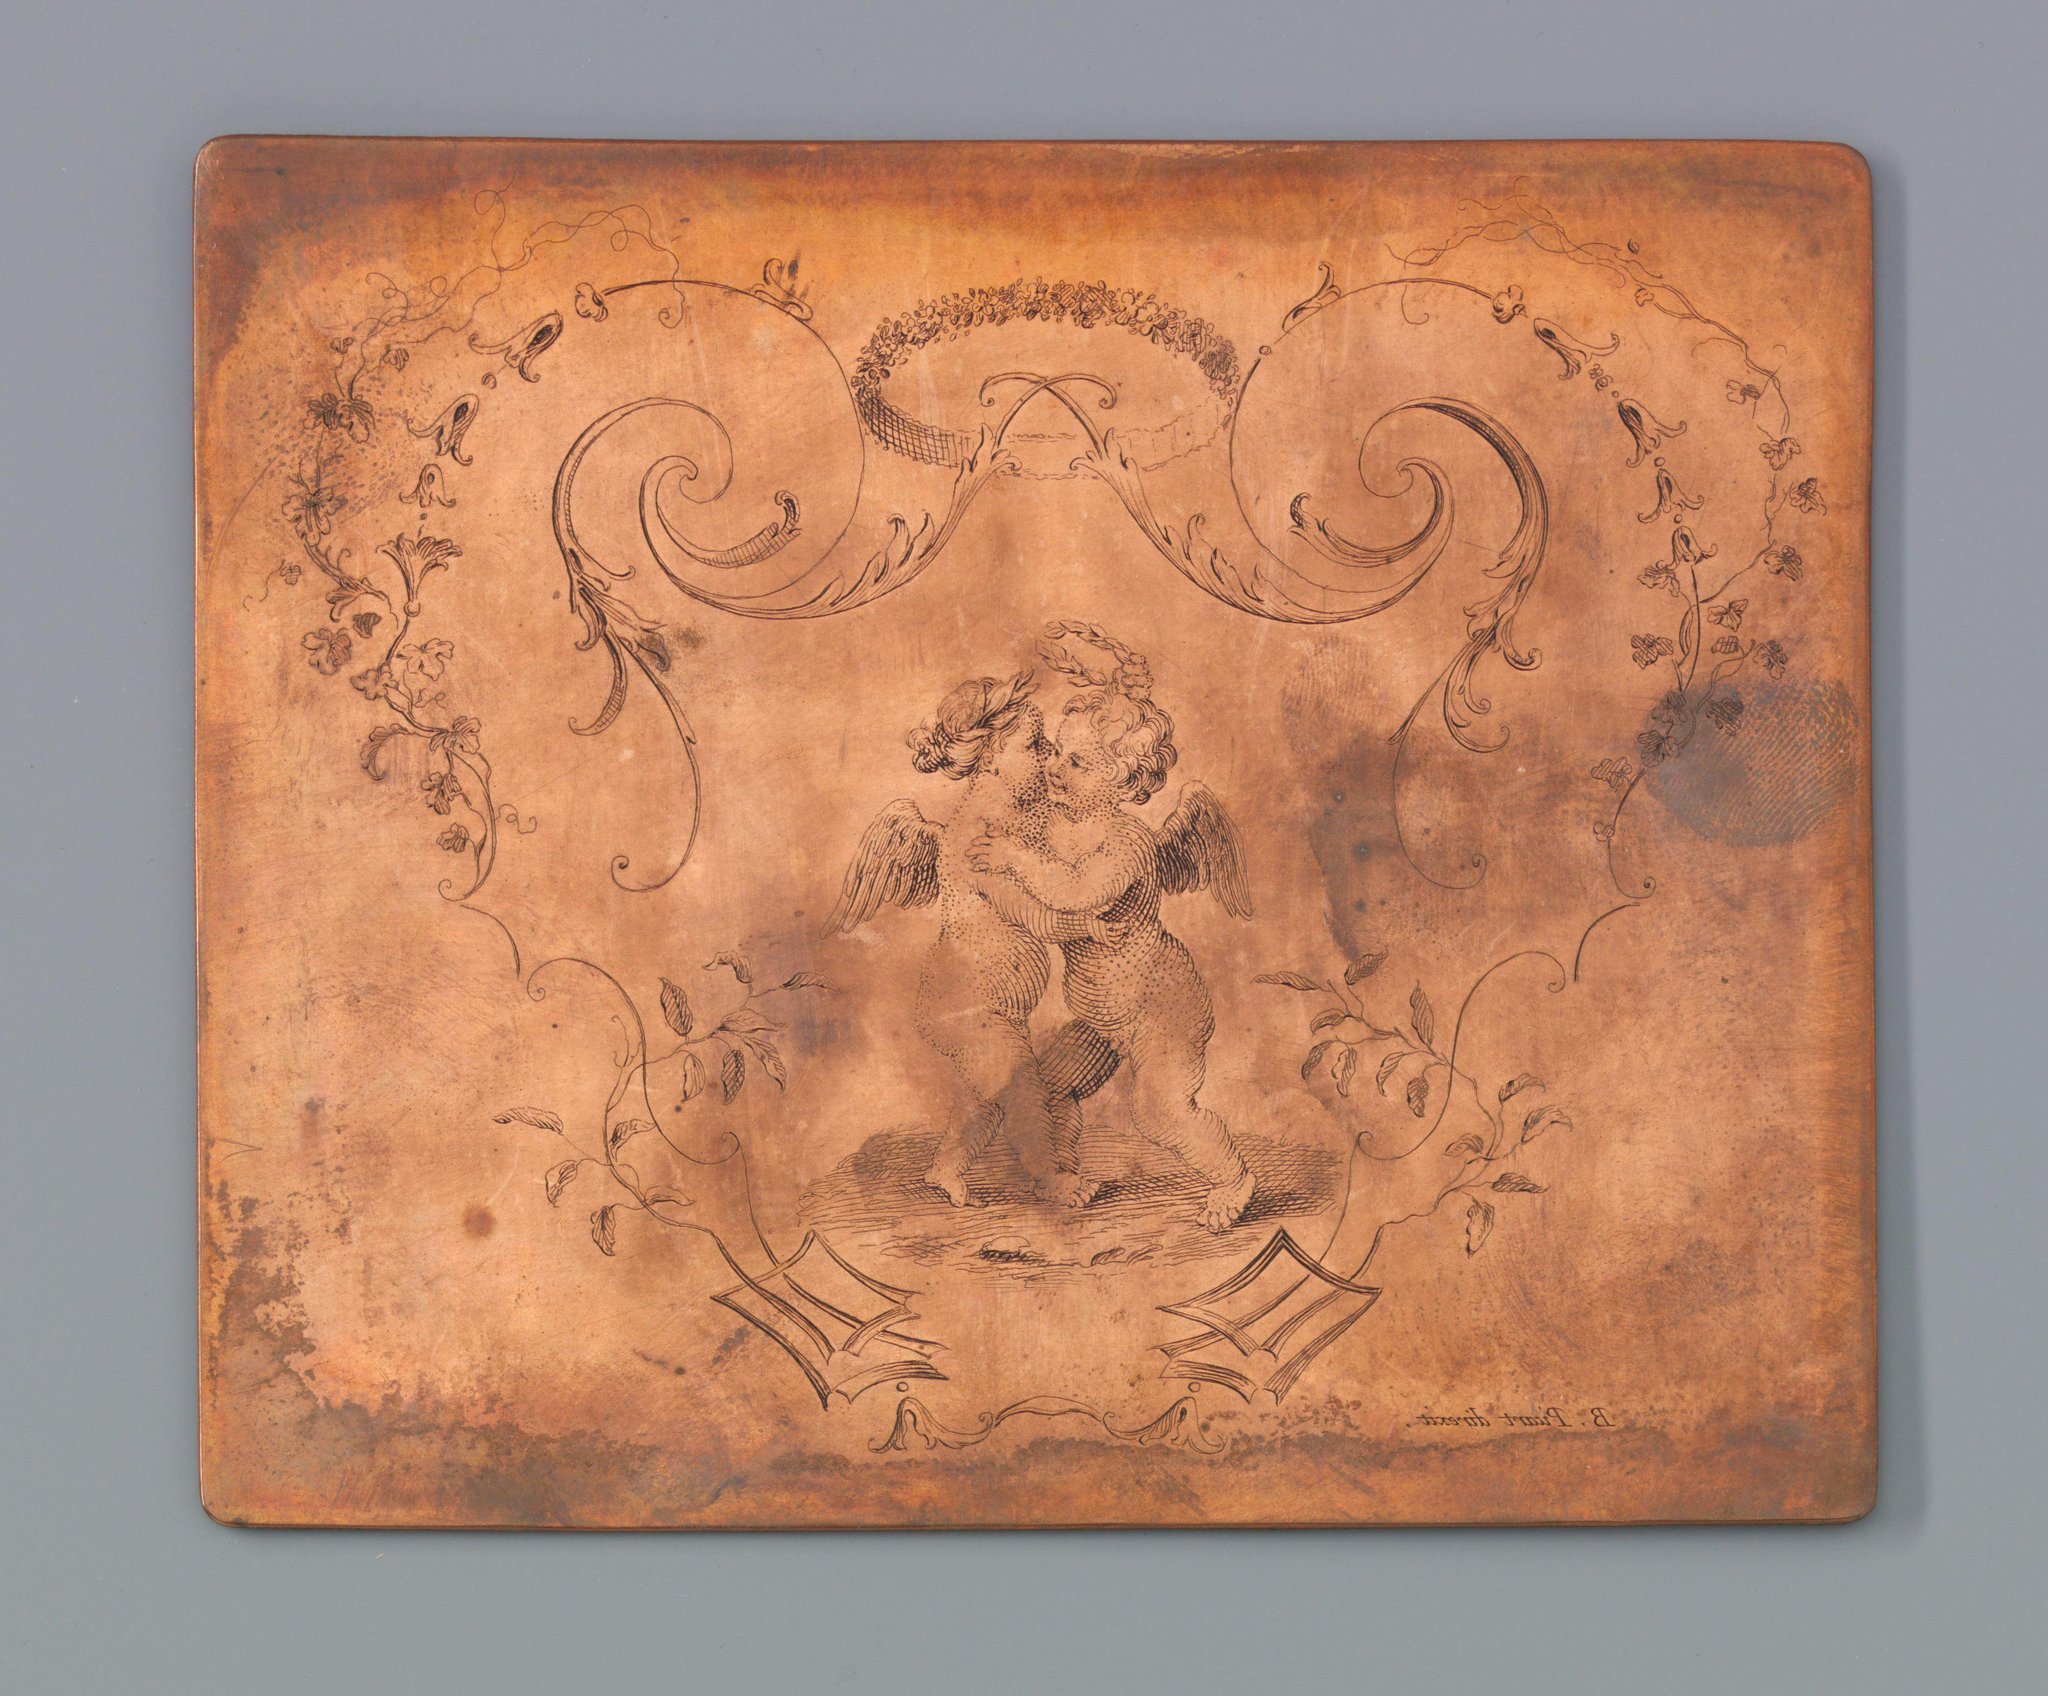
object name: copper plate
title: Twee putti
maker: bernard picart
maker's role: draughtsman, print maker, publisher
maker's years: 1673-1733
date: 1683-1733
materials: copper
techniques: etching